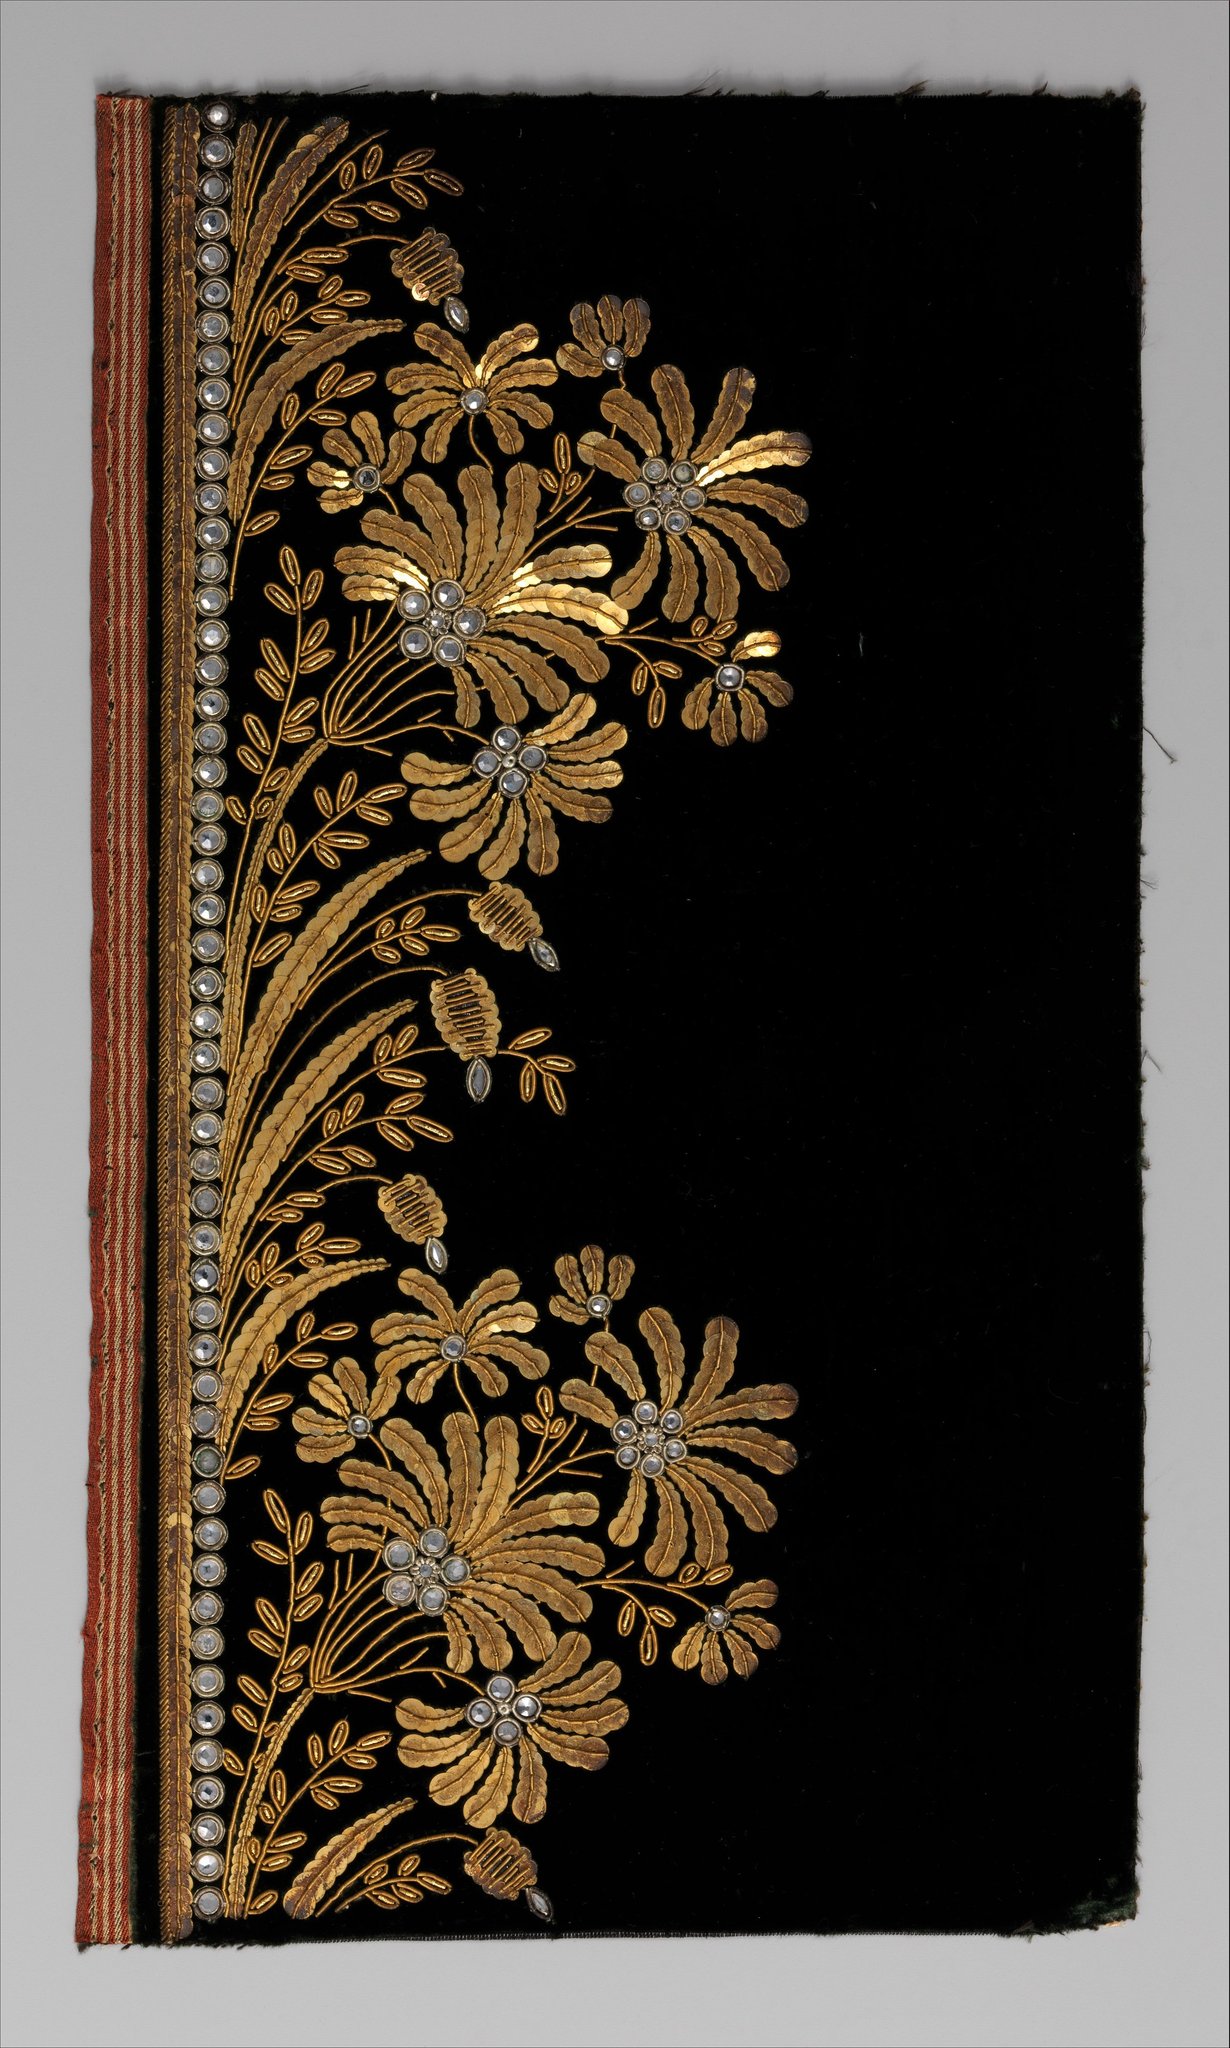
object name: sample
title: Embroidery sample for a man’s suit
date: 1800-1815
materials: glass, metal thread, silk, velvet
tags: flowers